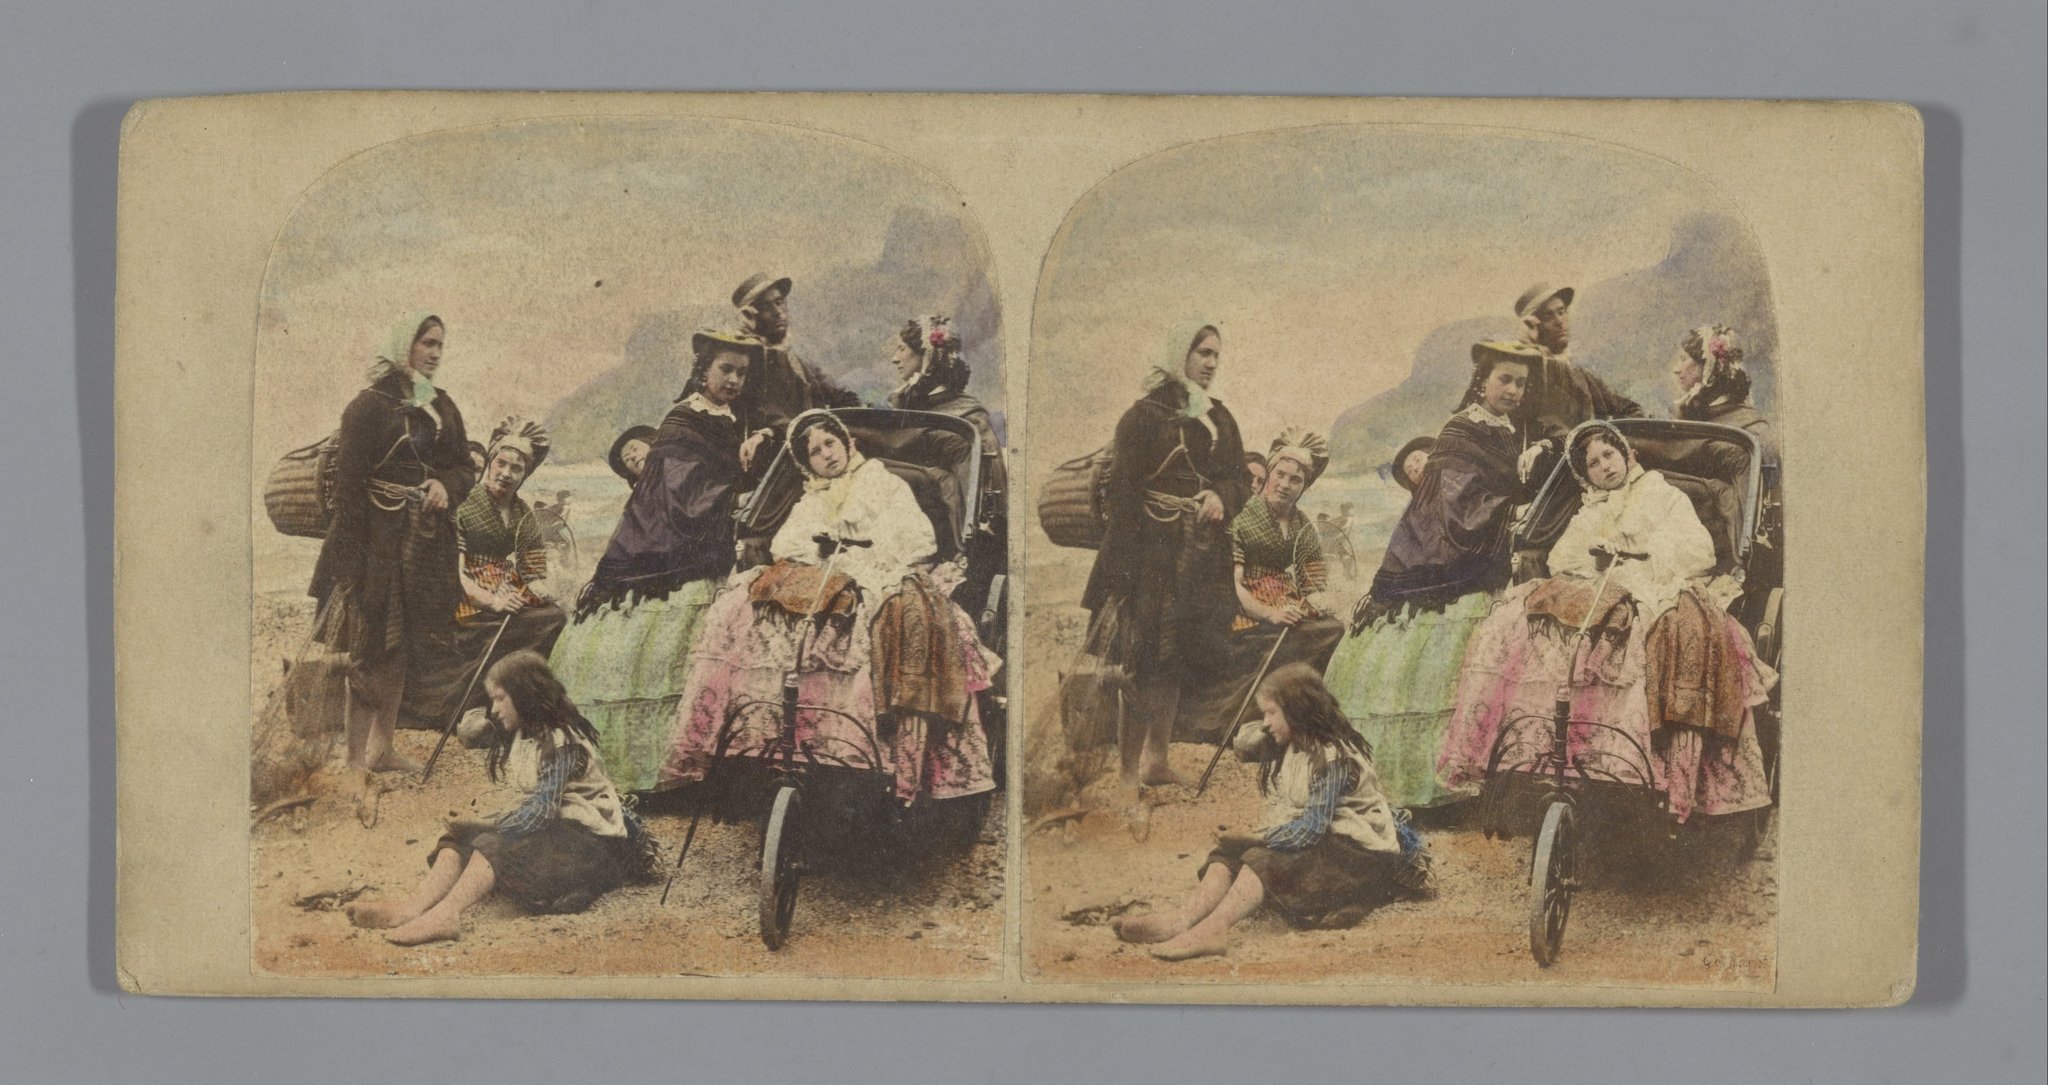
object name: stereograph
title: Groep mensen op een strand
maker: Anonymous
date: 1852-1863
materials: cardboard, paper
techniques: albumen print, hand coloring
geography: london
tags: in or beside the water (on the beach)